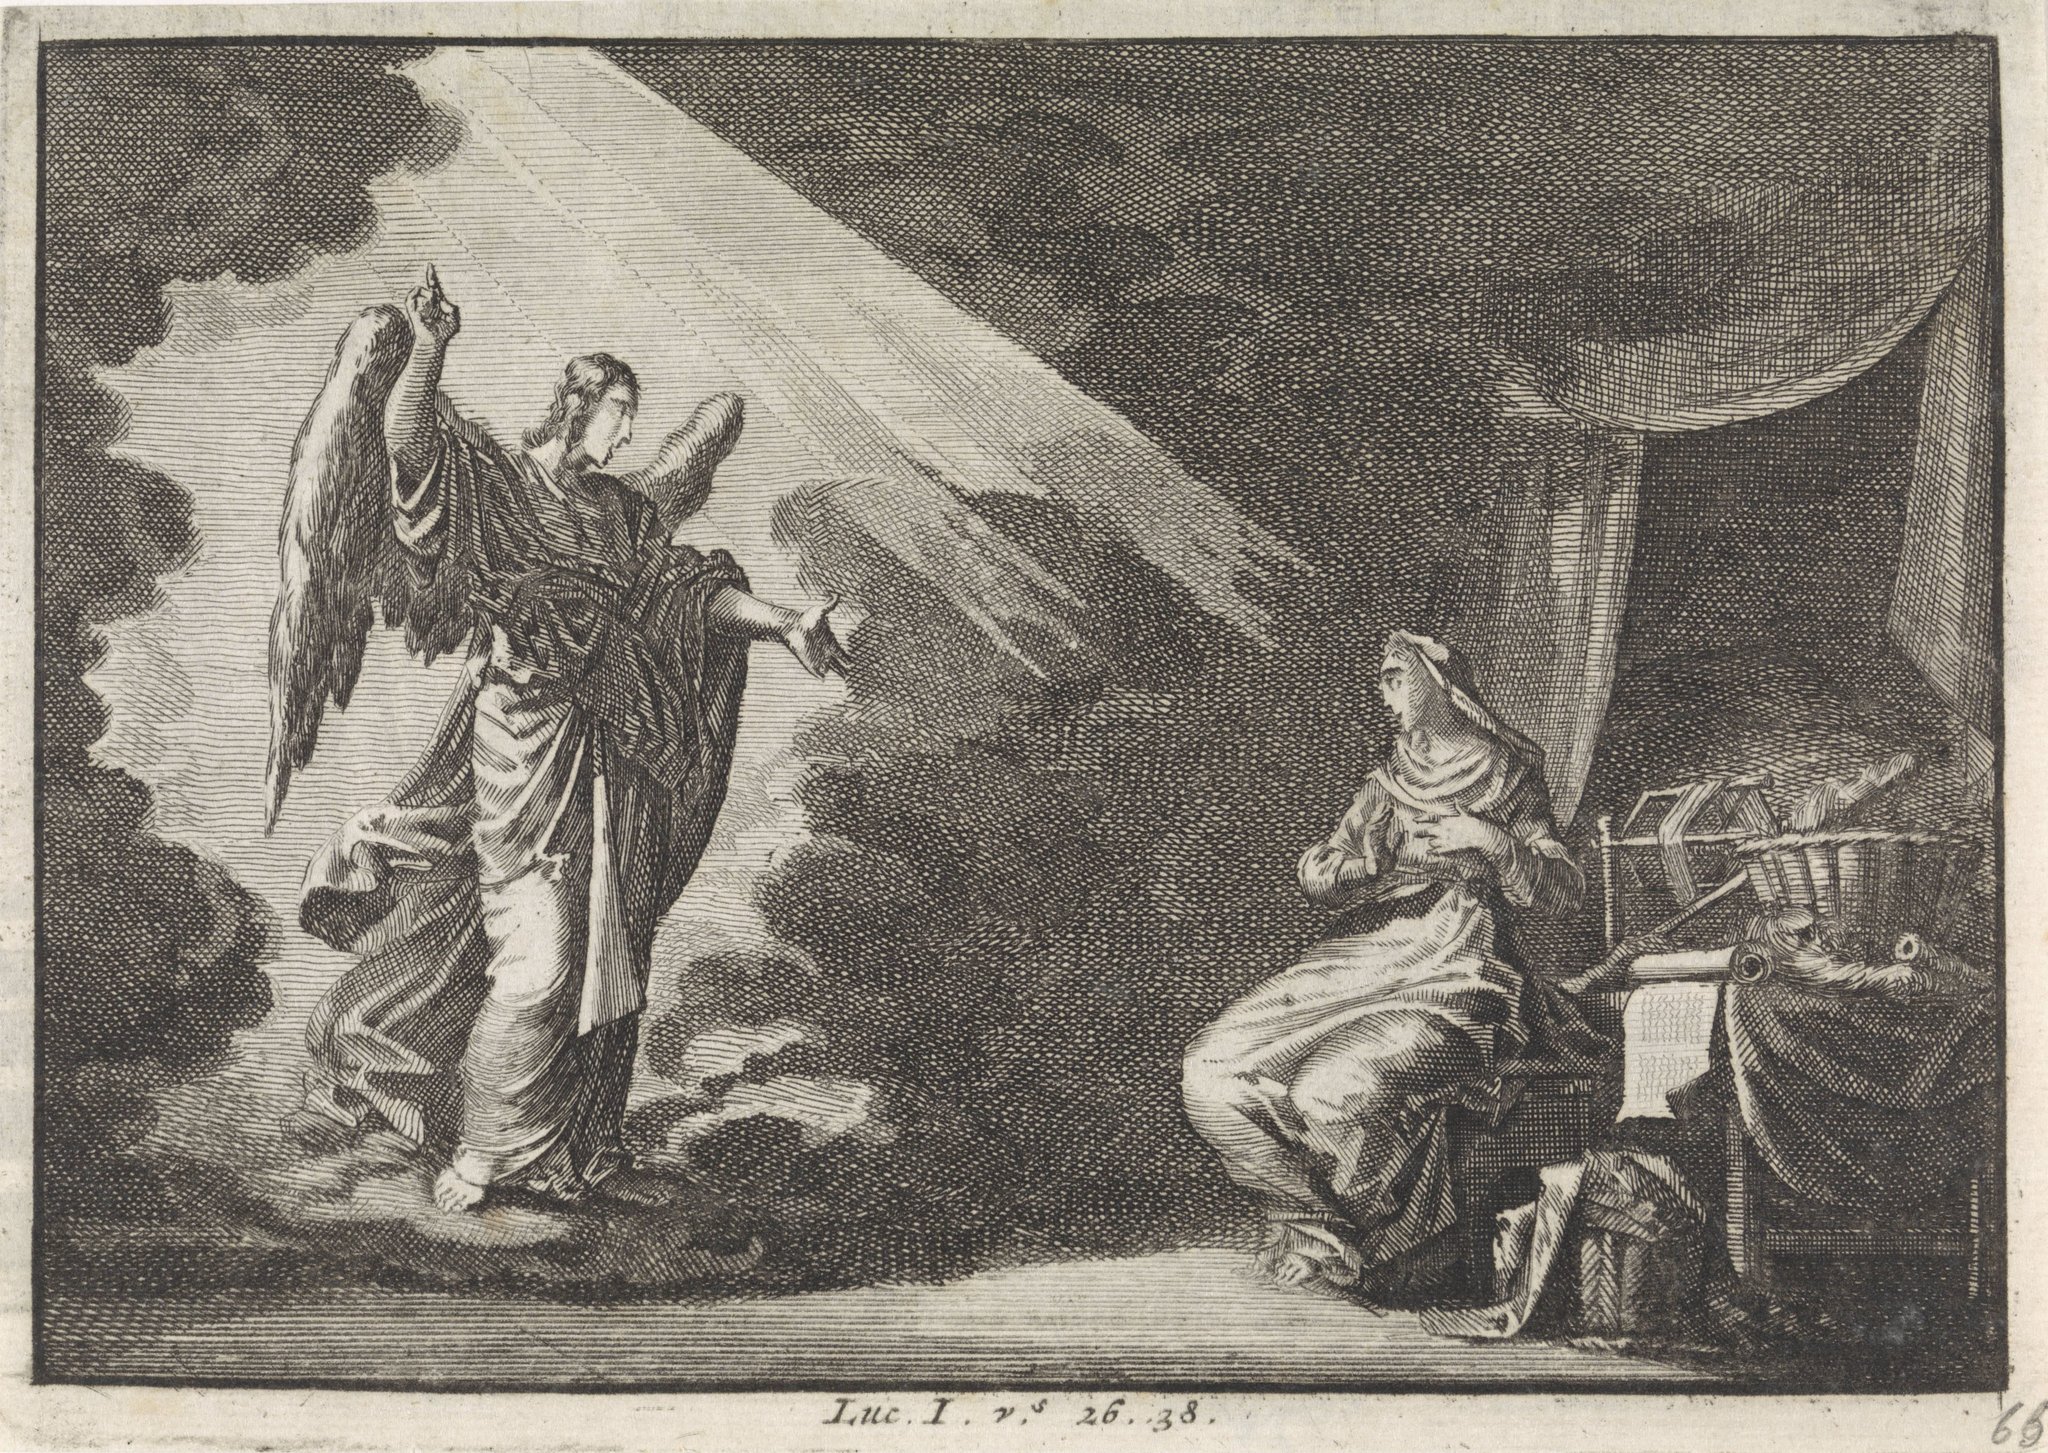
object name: book illustration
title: Annunciatie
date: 1703-1762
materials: paper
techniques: etching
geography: haarlem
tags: the annunciation: mary, usually reading, is visited by the angel (sometimes a woman overhears the conversation)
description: De prent komt een eerste keer voor als boekillustratie voor David Martin. Historie des Ouden en Nieuwen Testaments. Amsterdam, Pieter Mortier, 1703. Deel II. De boekillustraties voor de Mortierbijbel hebben verschillende staten en kopieën, waarbij de chronologische volgorde moeilijk te achterhalen valt. Als boekillustraties werden ze bovendien herhaaldelijk opnieuw gebruikt voor andere boekwerken.